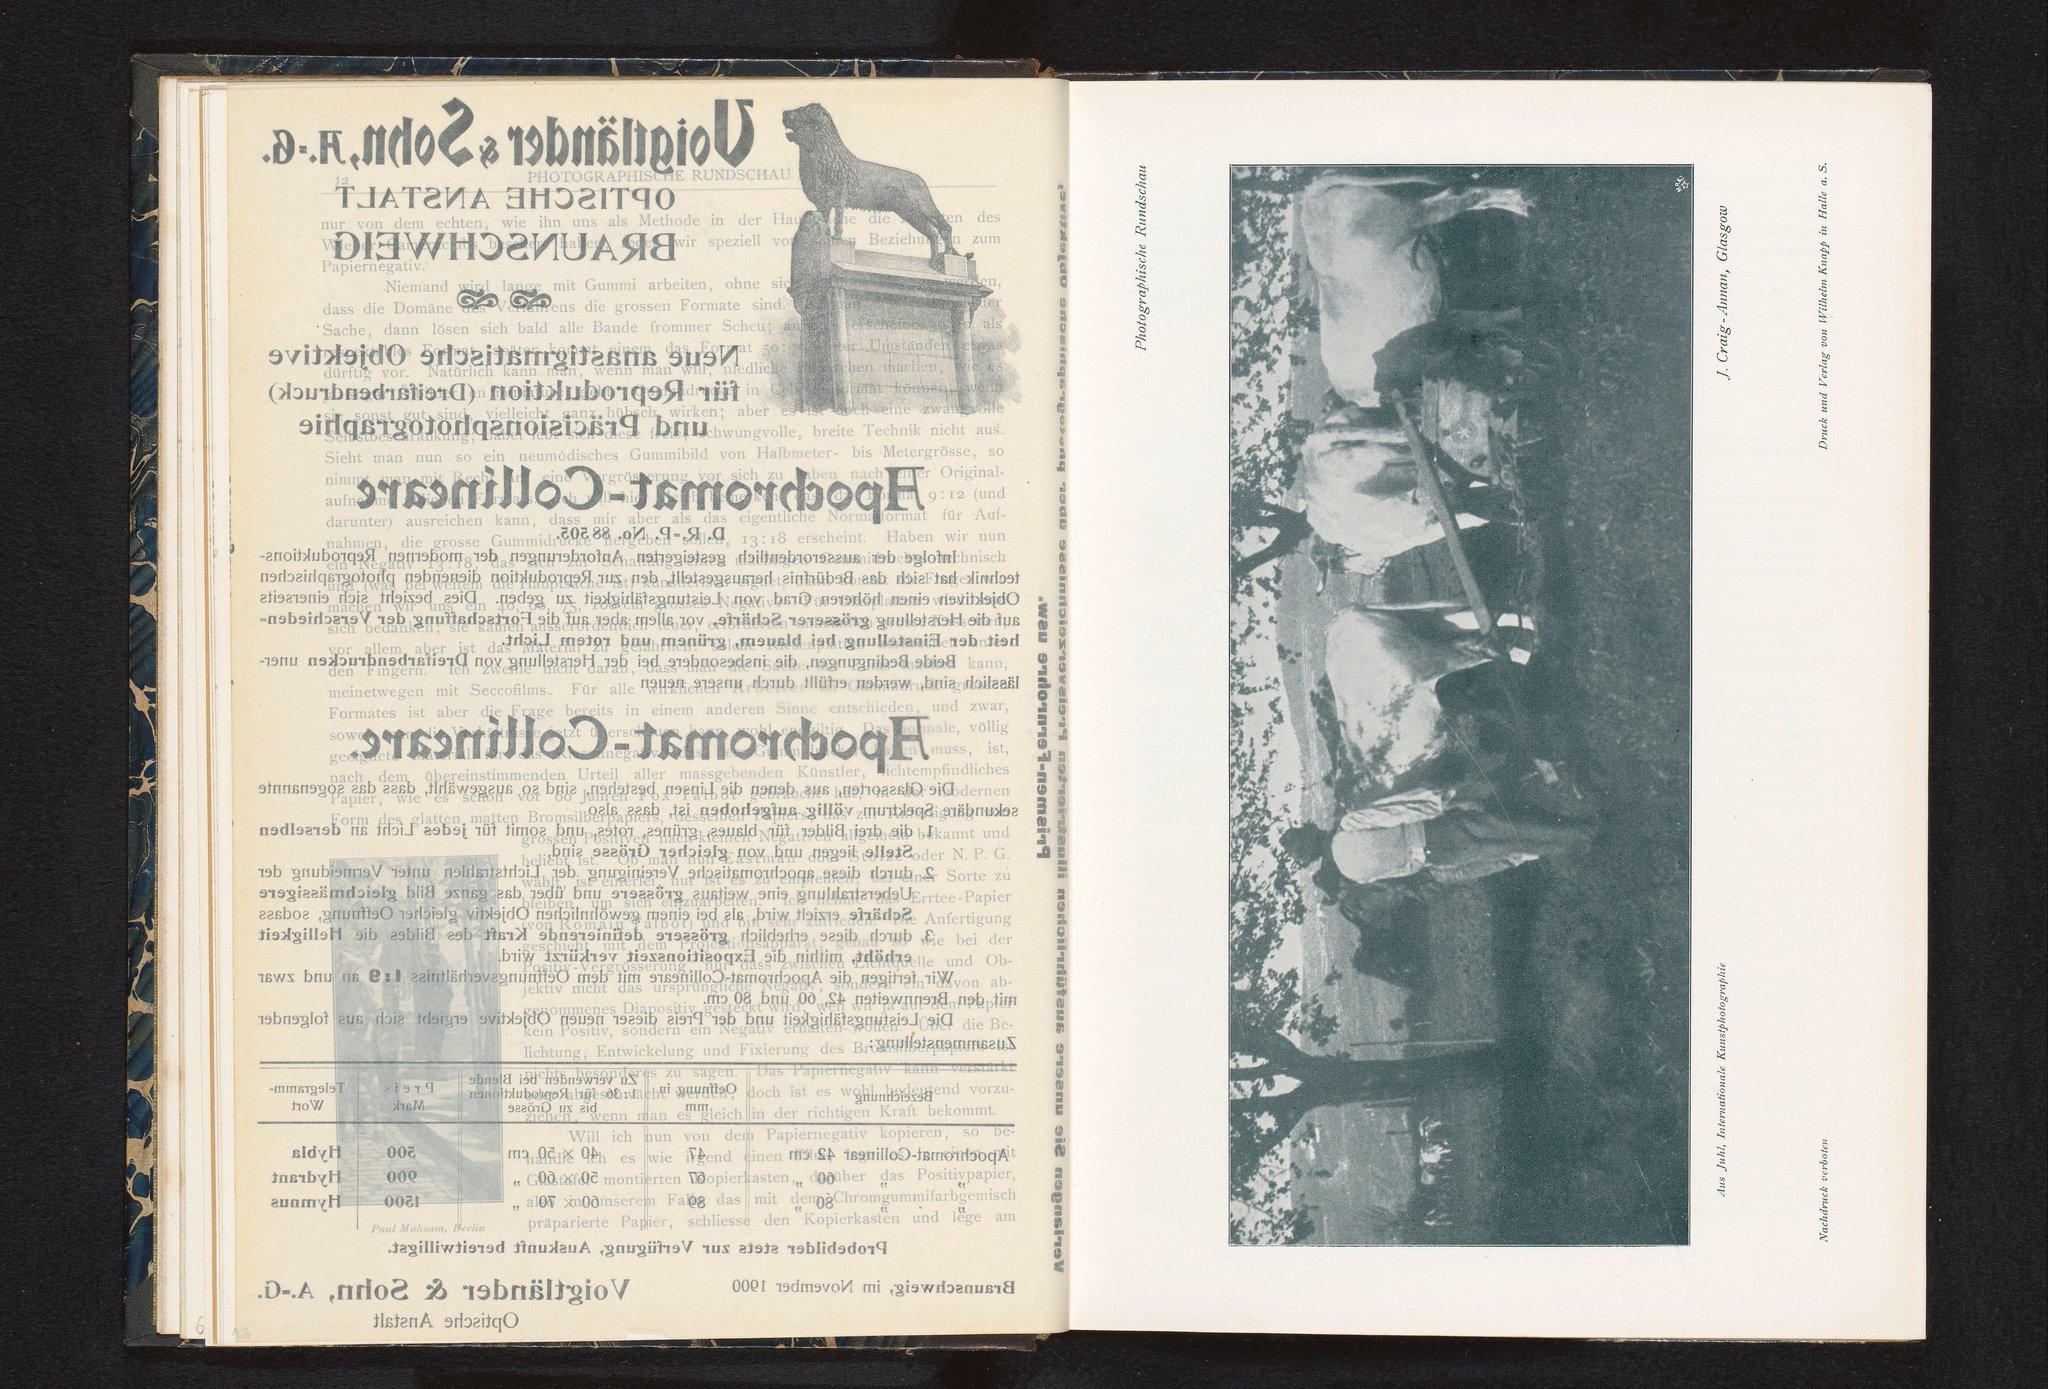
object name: page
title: Aus Juhl, Internationale Kunstphotographie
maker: james craig annan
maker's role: fotograaf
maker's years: 1864-1946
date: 1896-1901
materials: paper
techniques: autotype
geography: berlin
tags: cow, meadow, pasture, farmers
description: Prent tegenover pagina 12, achter semi-transparante omslag met reclameboodschap.